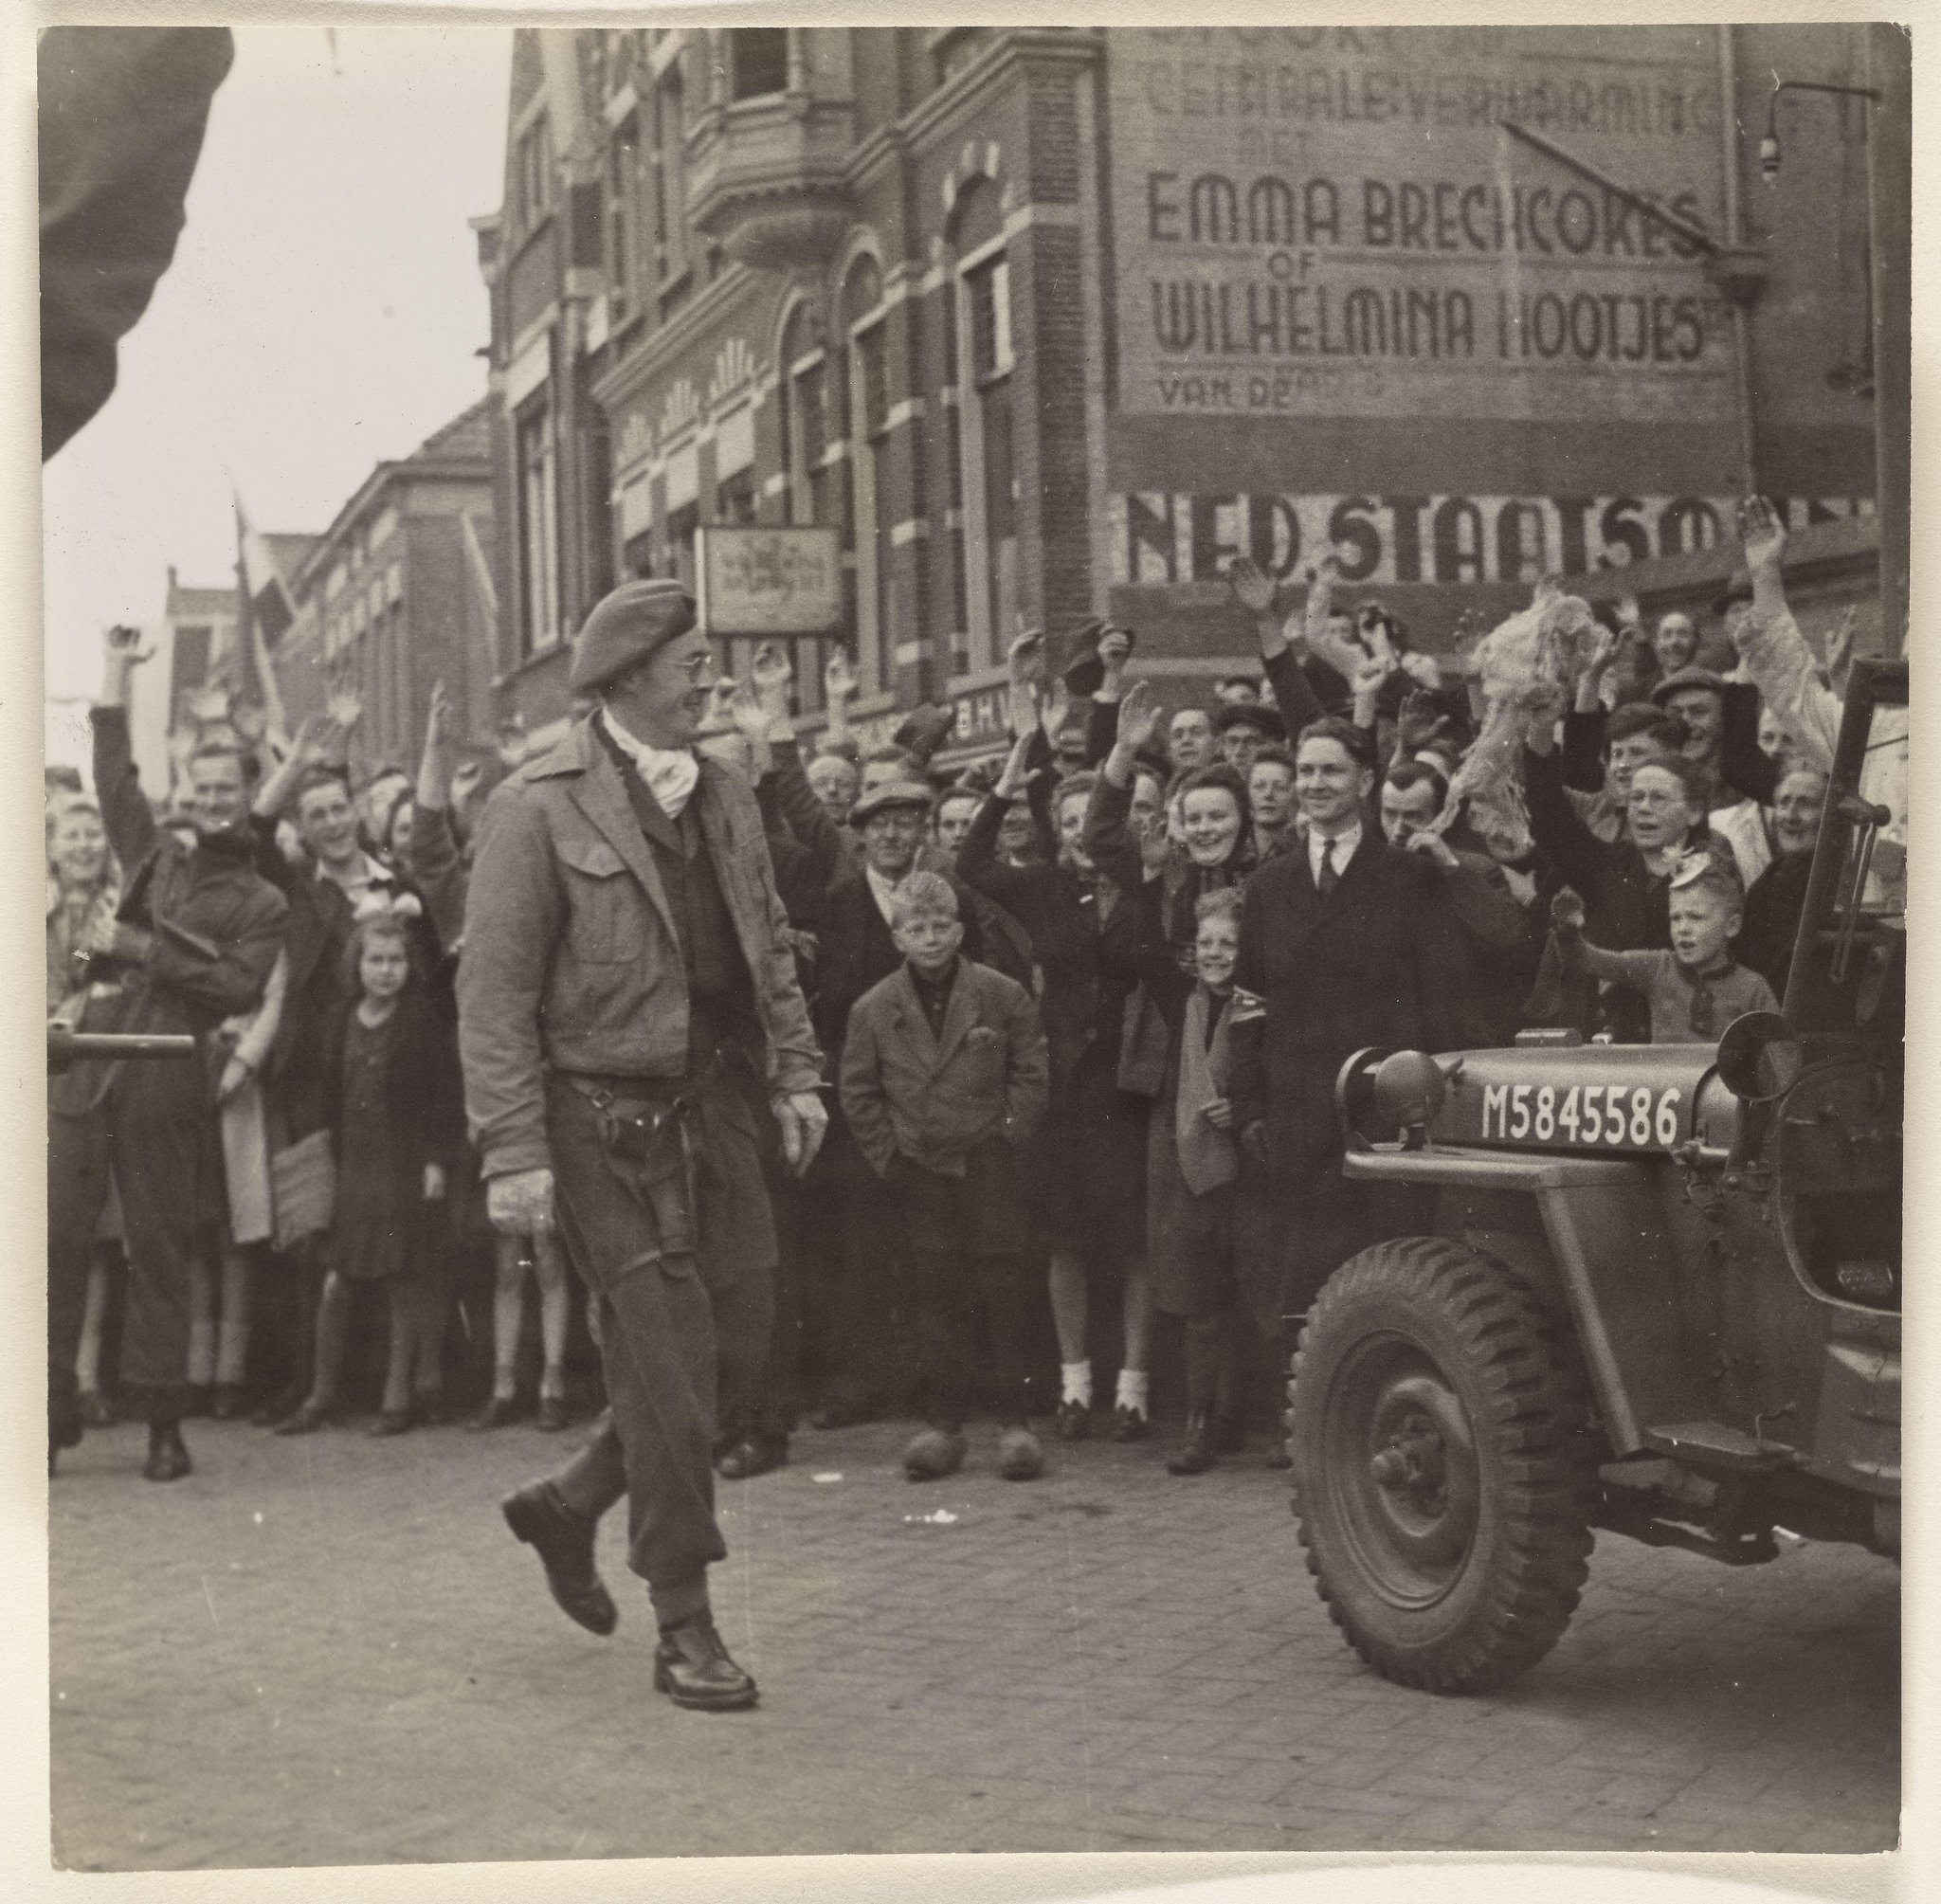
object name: photograph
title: Bernhard bezoekt bevrijd Leeuwarden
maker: louis woudhuysen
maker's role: fotograaf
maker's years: 1912-1985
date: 1904-1945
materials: photographic support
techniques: photography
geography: leeuwarden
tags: utrecht, bernhard (prins der nederlanden)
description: Prins Bernhard ging meteen na de bevrijding van Noord-Oost Nederland op bezoek in diverse steden. [Baruch, Jet, 2006].